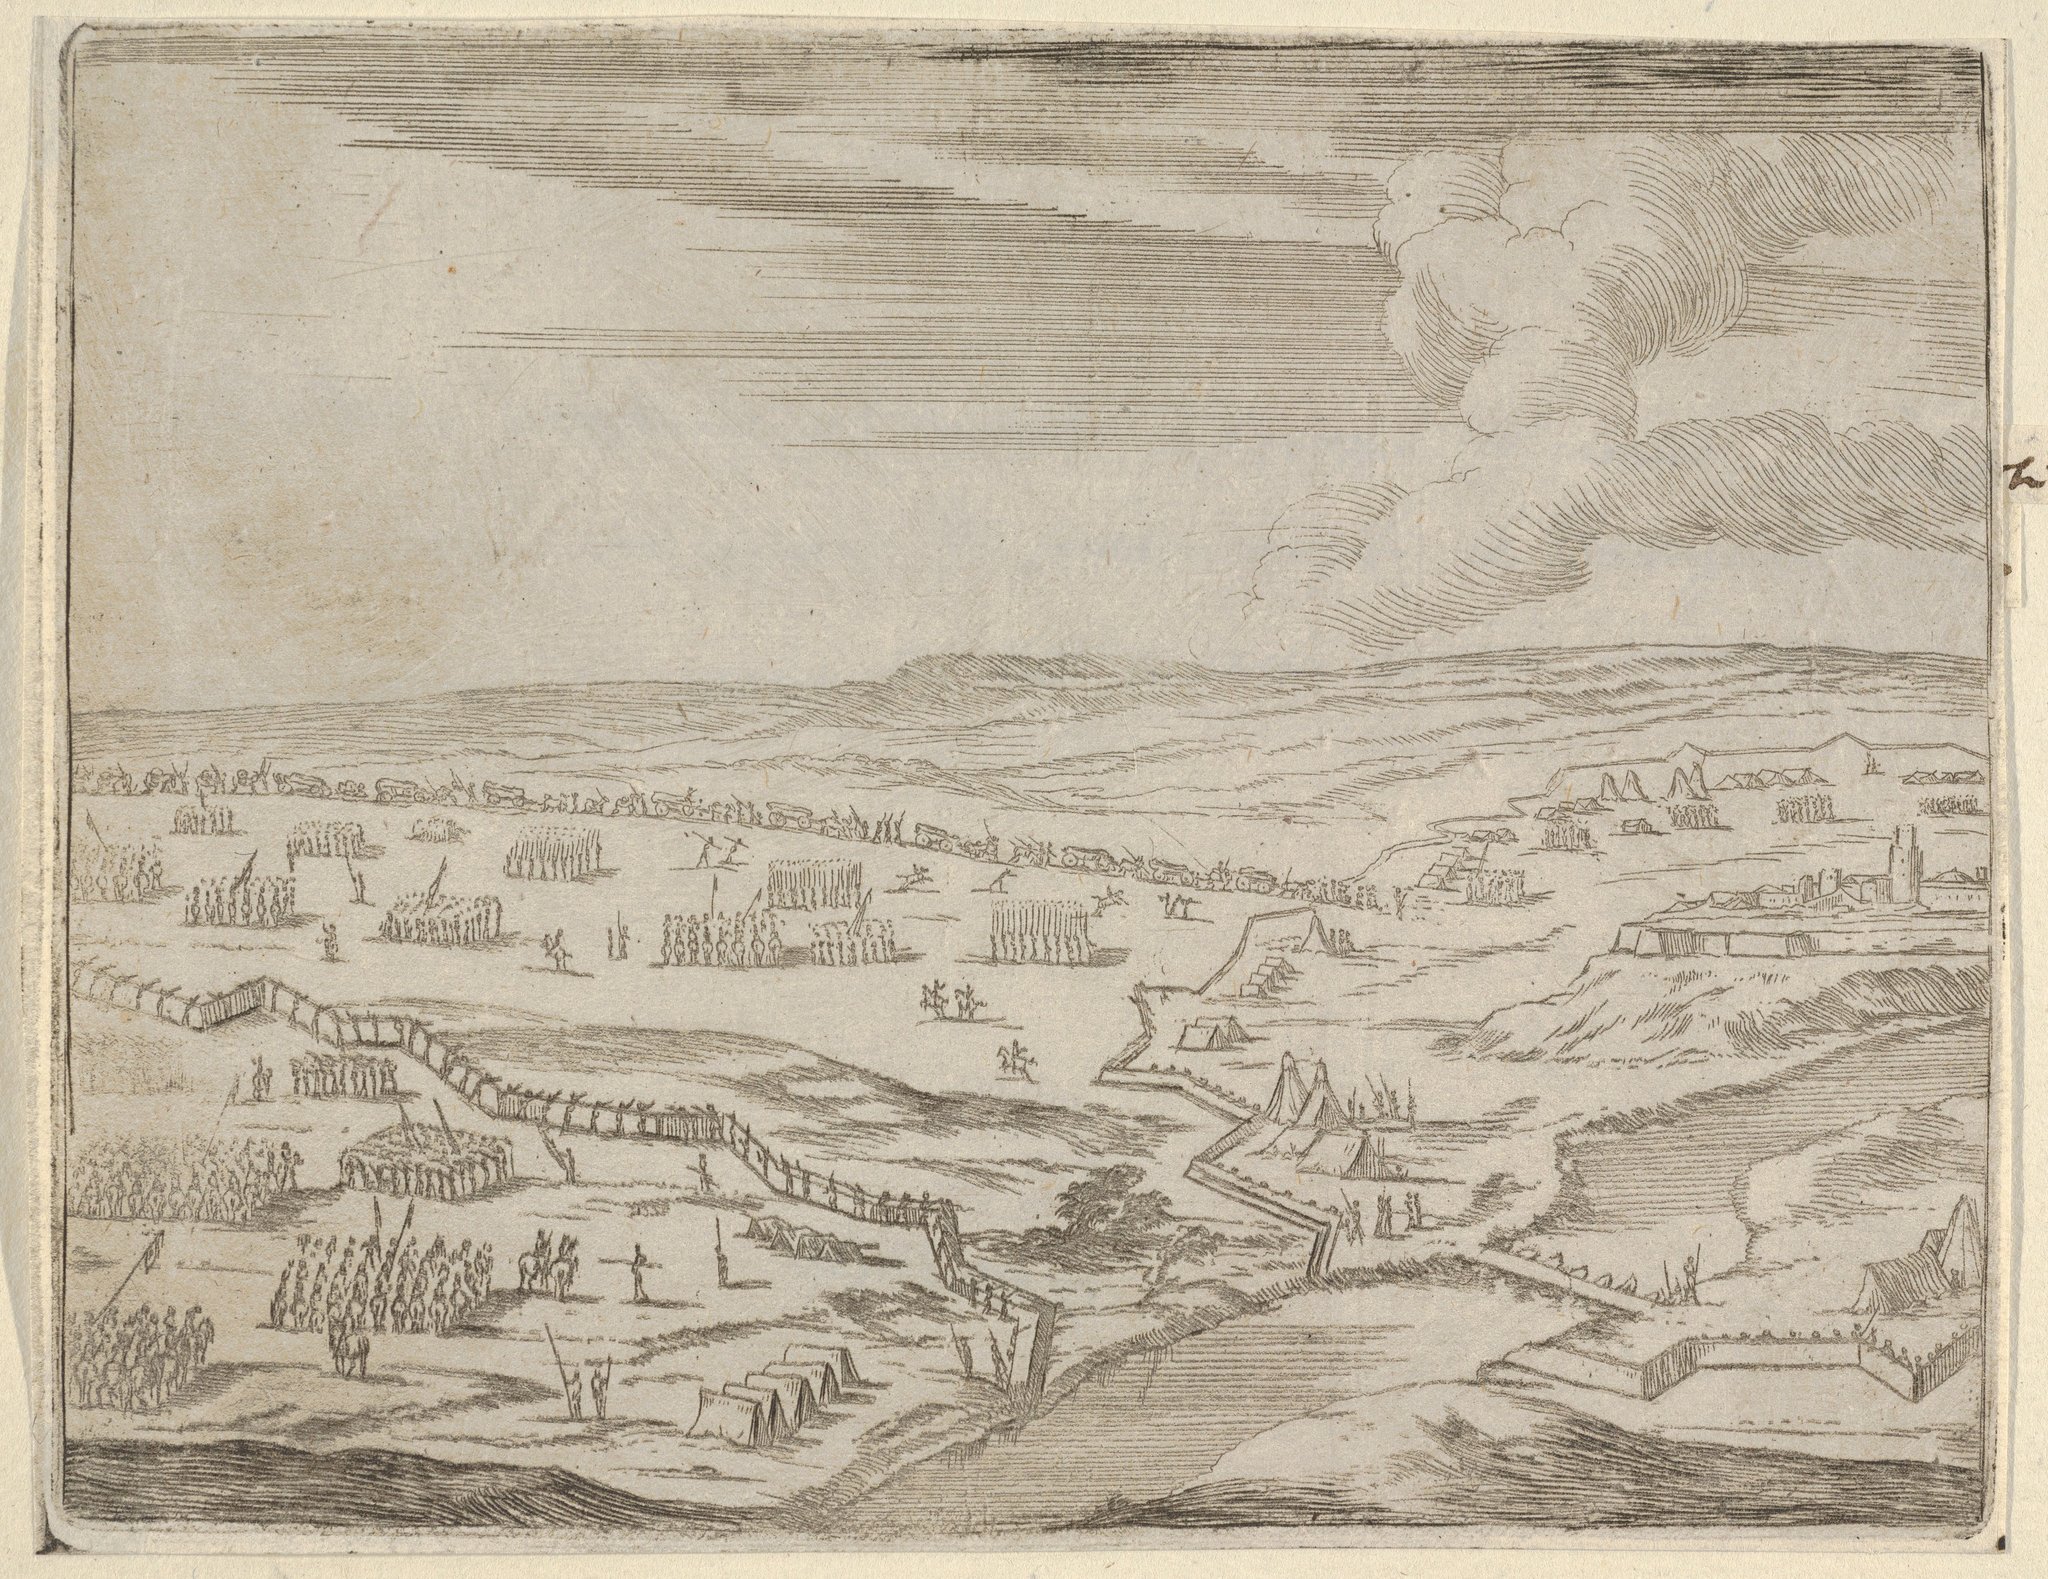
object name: print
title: Francesco I d'Este Approches the Camp of the Enemy Under the Pretext of Battle, Although he Obtains their Surrender Without Battle, from "L'Idea di un Principe ed Eroe Cristiano in Francesco I d'Este, di Modena e Reggio Duca VIII [...]"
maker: bartolomeo fenice (fénis)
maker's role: artist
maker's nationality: italian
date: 1659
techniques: etching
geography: italy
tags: battles,soldiers,men,landscapes